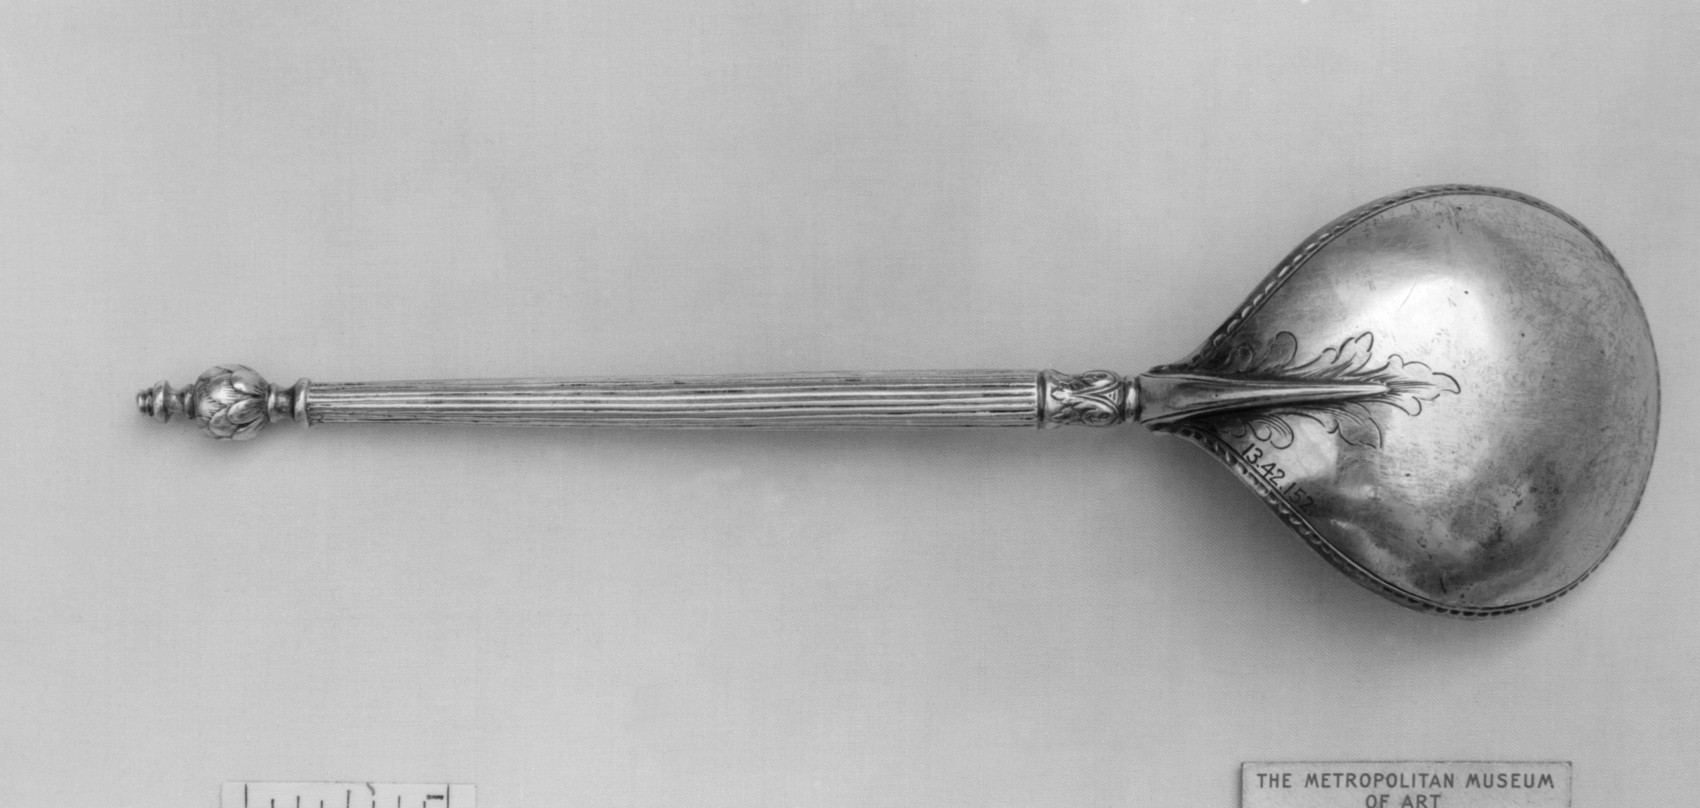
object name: fruitlet spoon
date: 1501-1700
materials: silver gilt